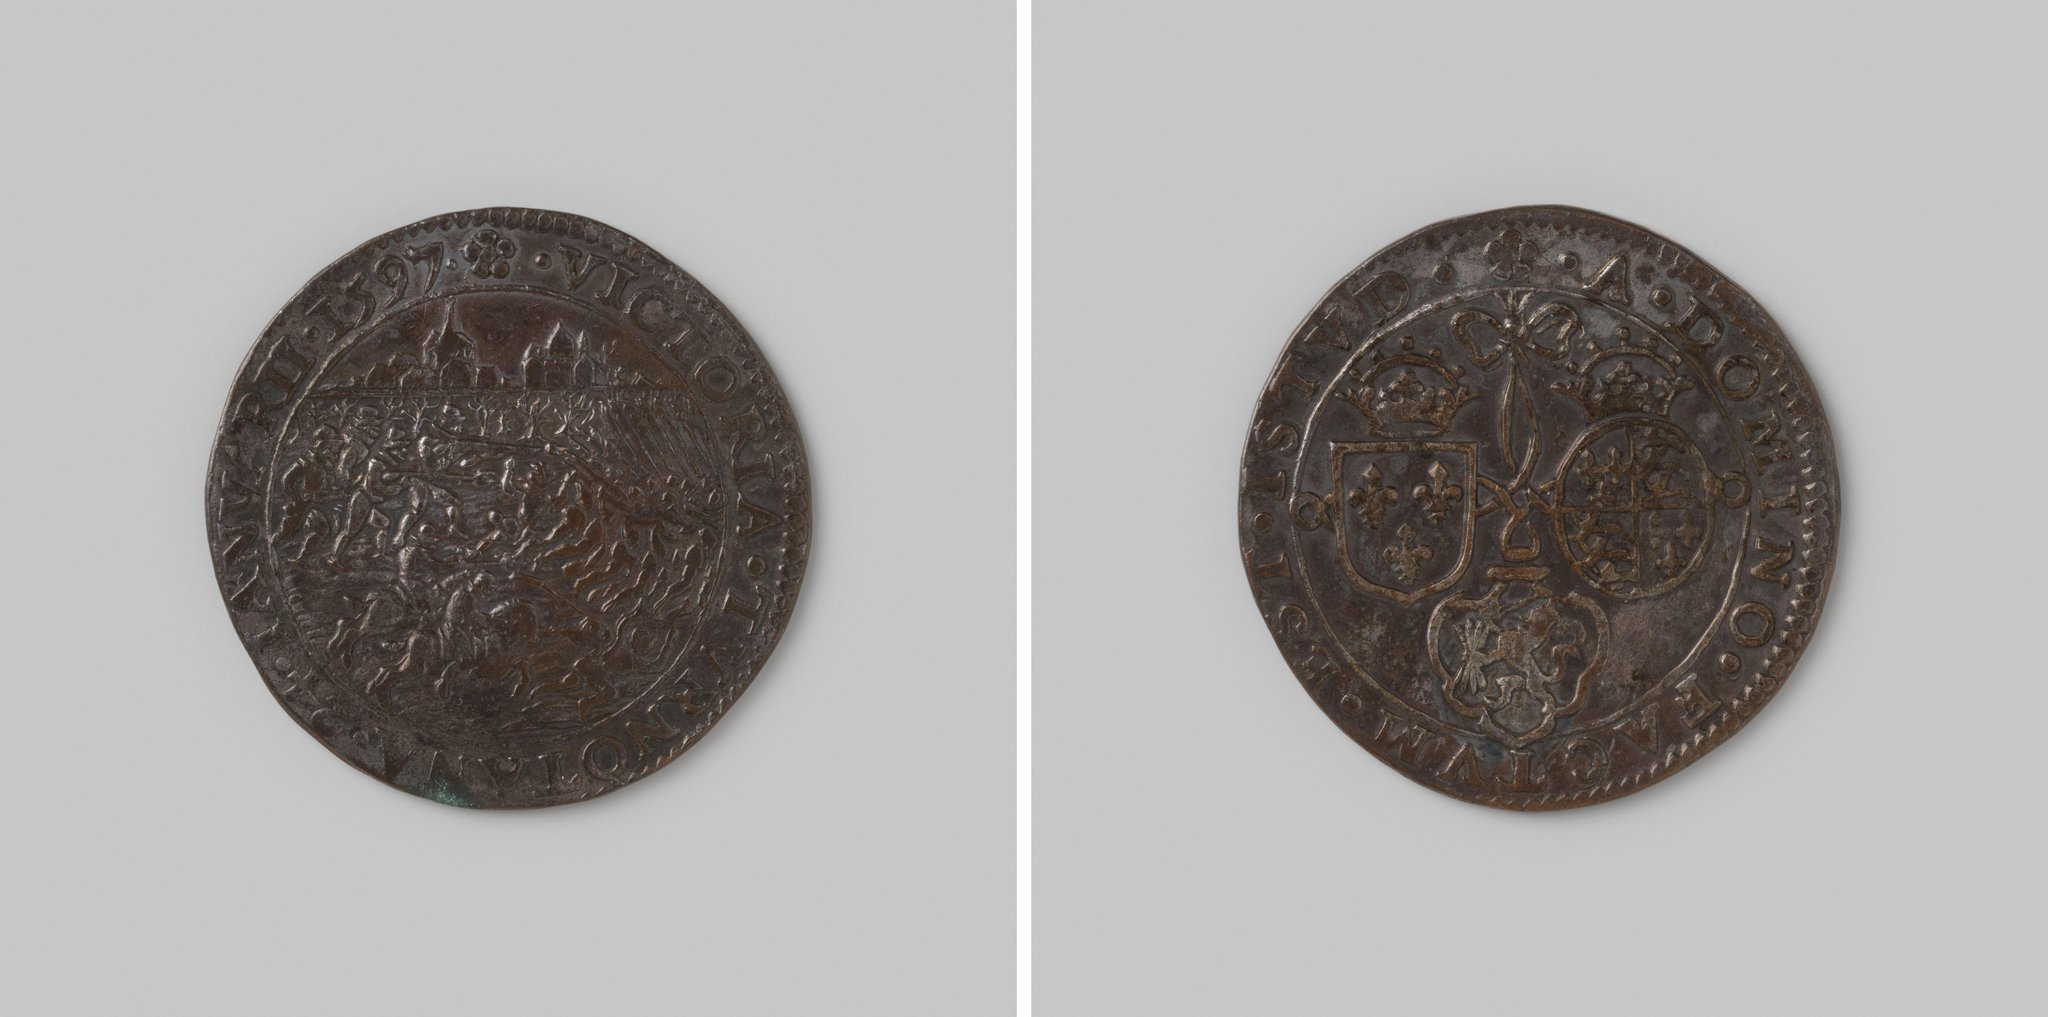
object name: history medal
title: Rekenpenning uit Dordrecht op de overwinning in de Slag bij bij Turnhout 1597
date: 1597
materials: silver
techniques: striking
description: Zilveren penning, op de voorzijde het verdrijven van het vijandelijke leger, met omschrift, op de keerzijde aan één lint de wapenschilden van Frankrijk, Groot Brittannië en Nederland, met omschrift.